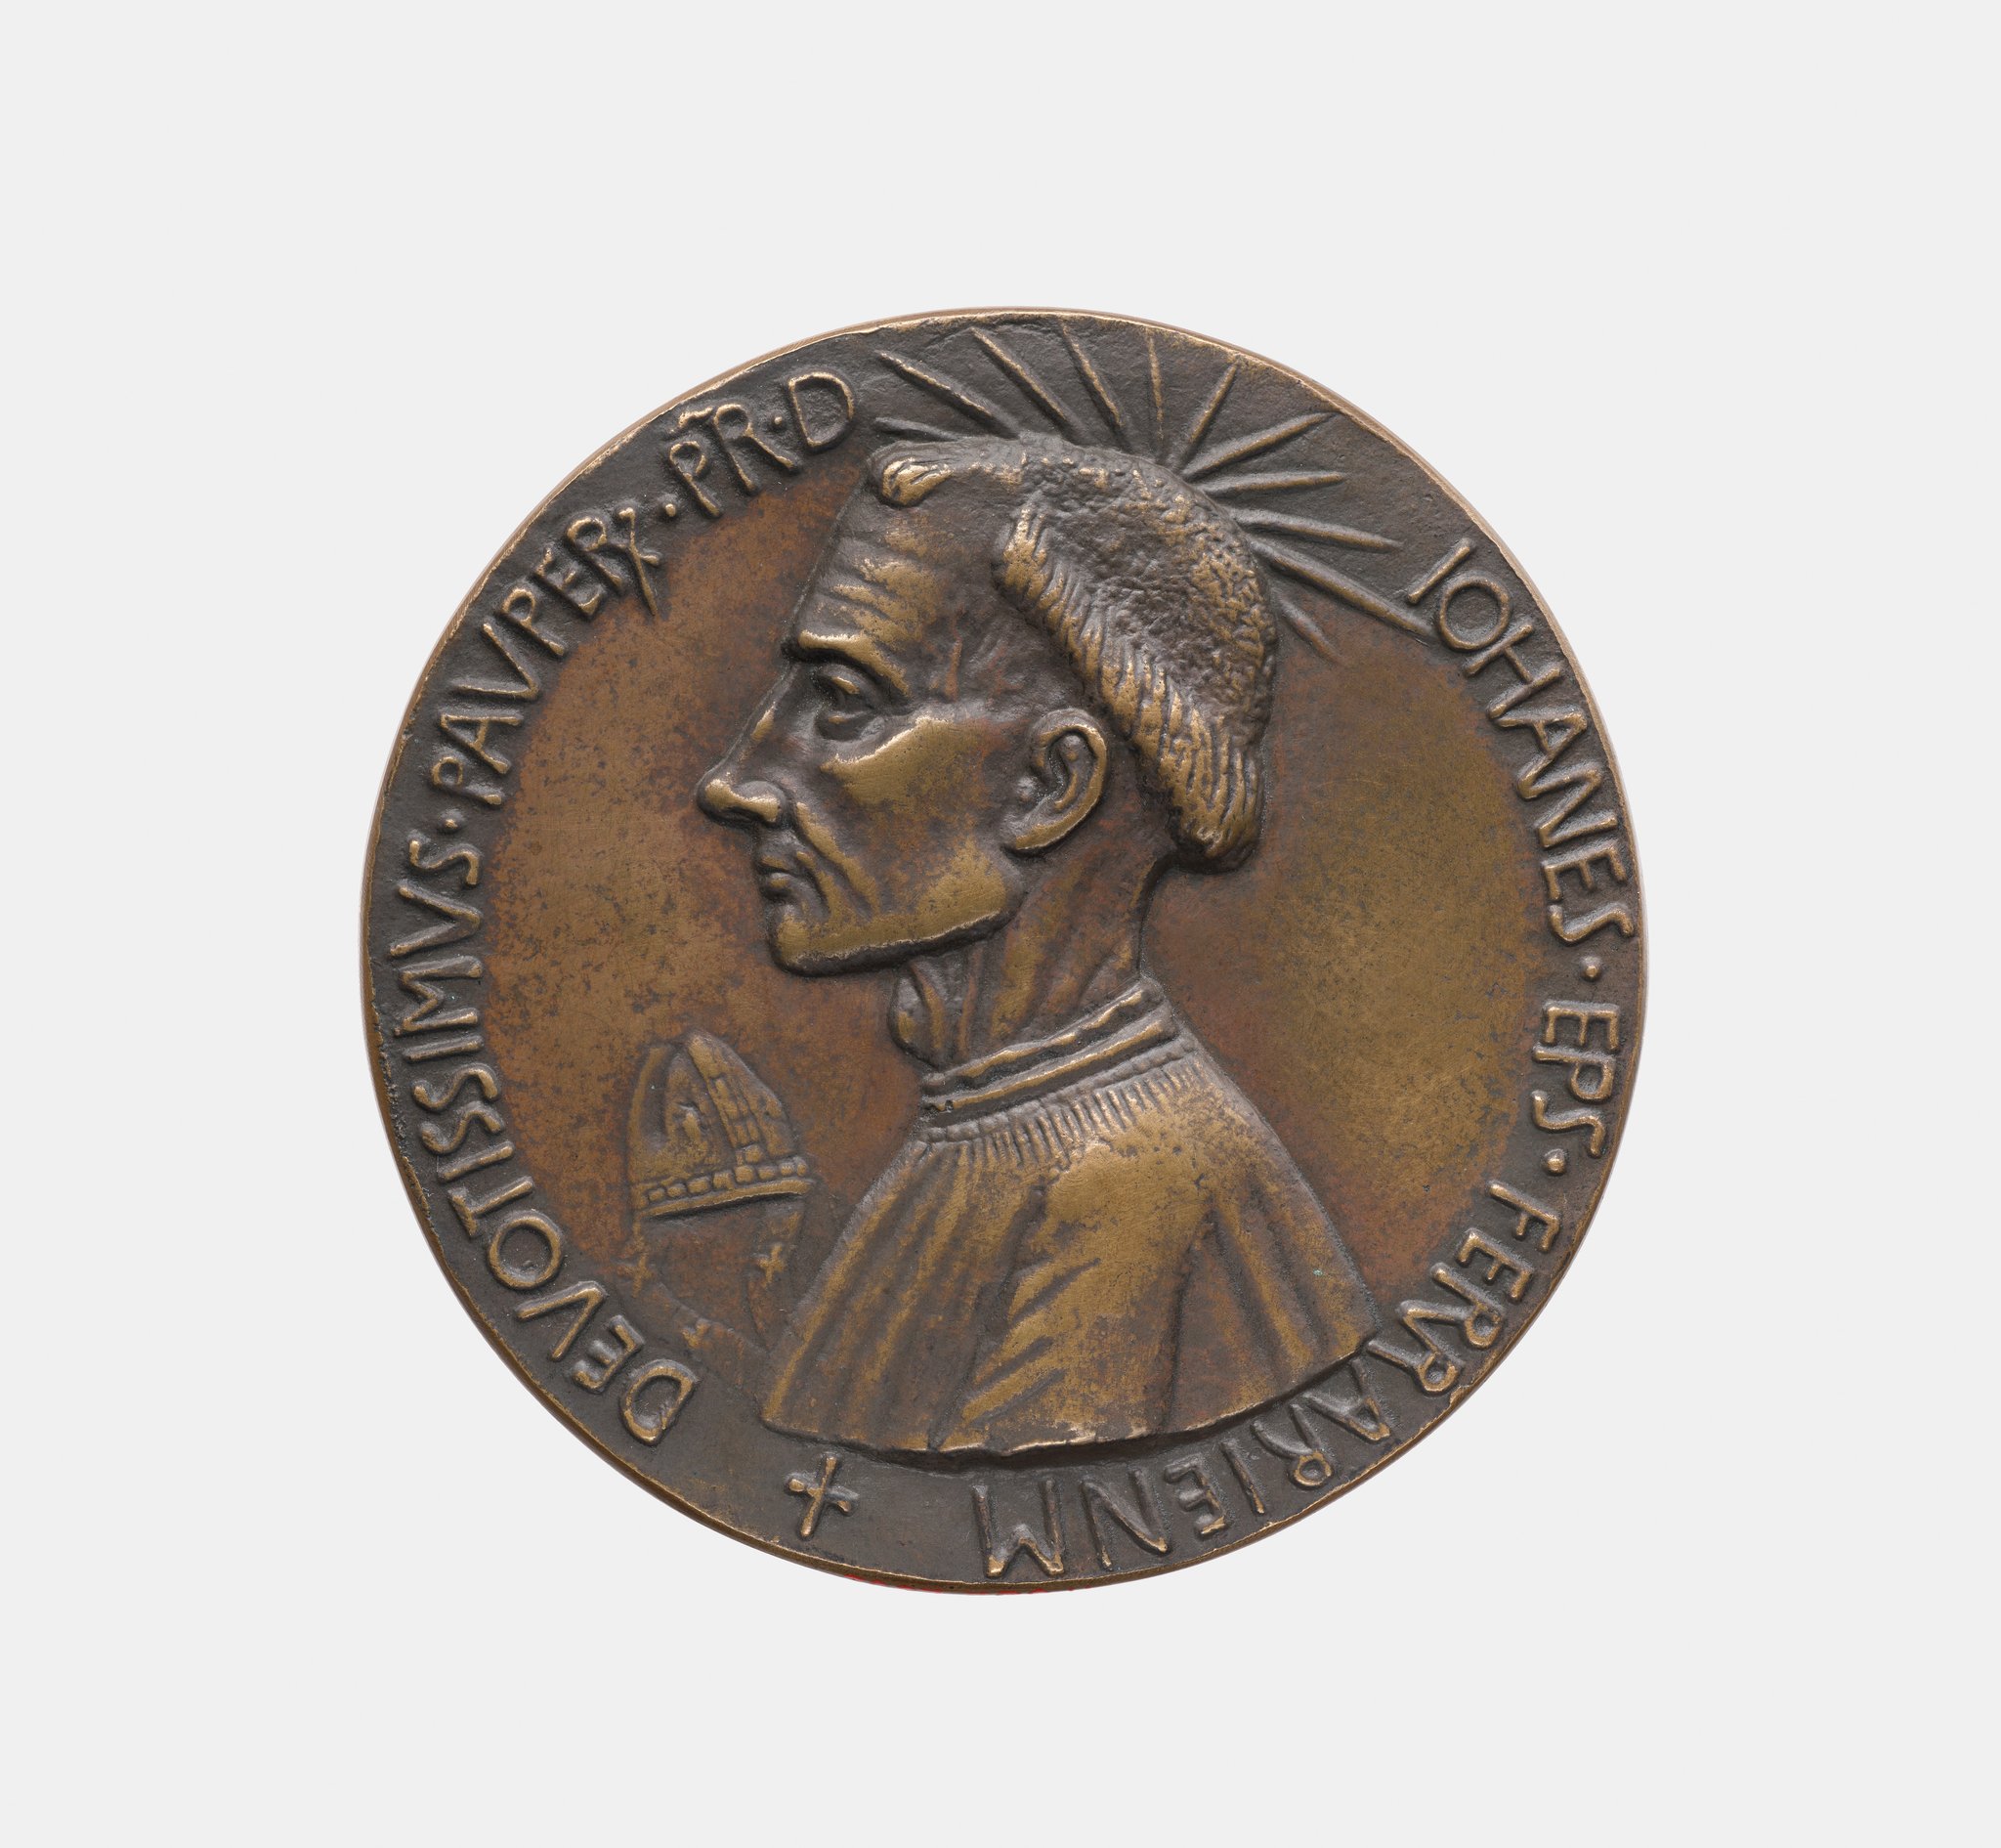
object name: medal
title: Beato Giovanni Tavelli da Tossignano 1386–1446, Bishop of Ferrara 1431–46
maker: antonio marescotti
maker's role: artist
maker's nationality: italian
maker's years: 1444-1462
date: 1446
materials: bronze